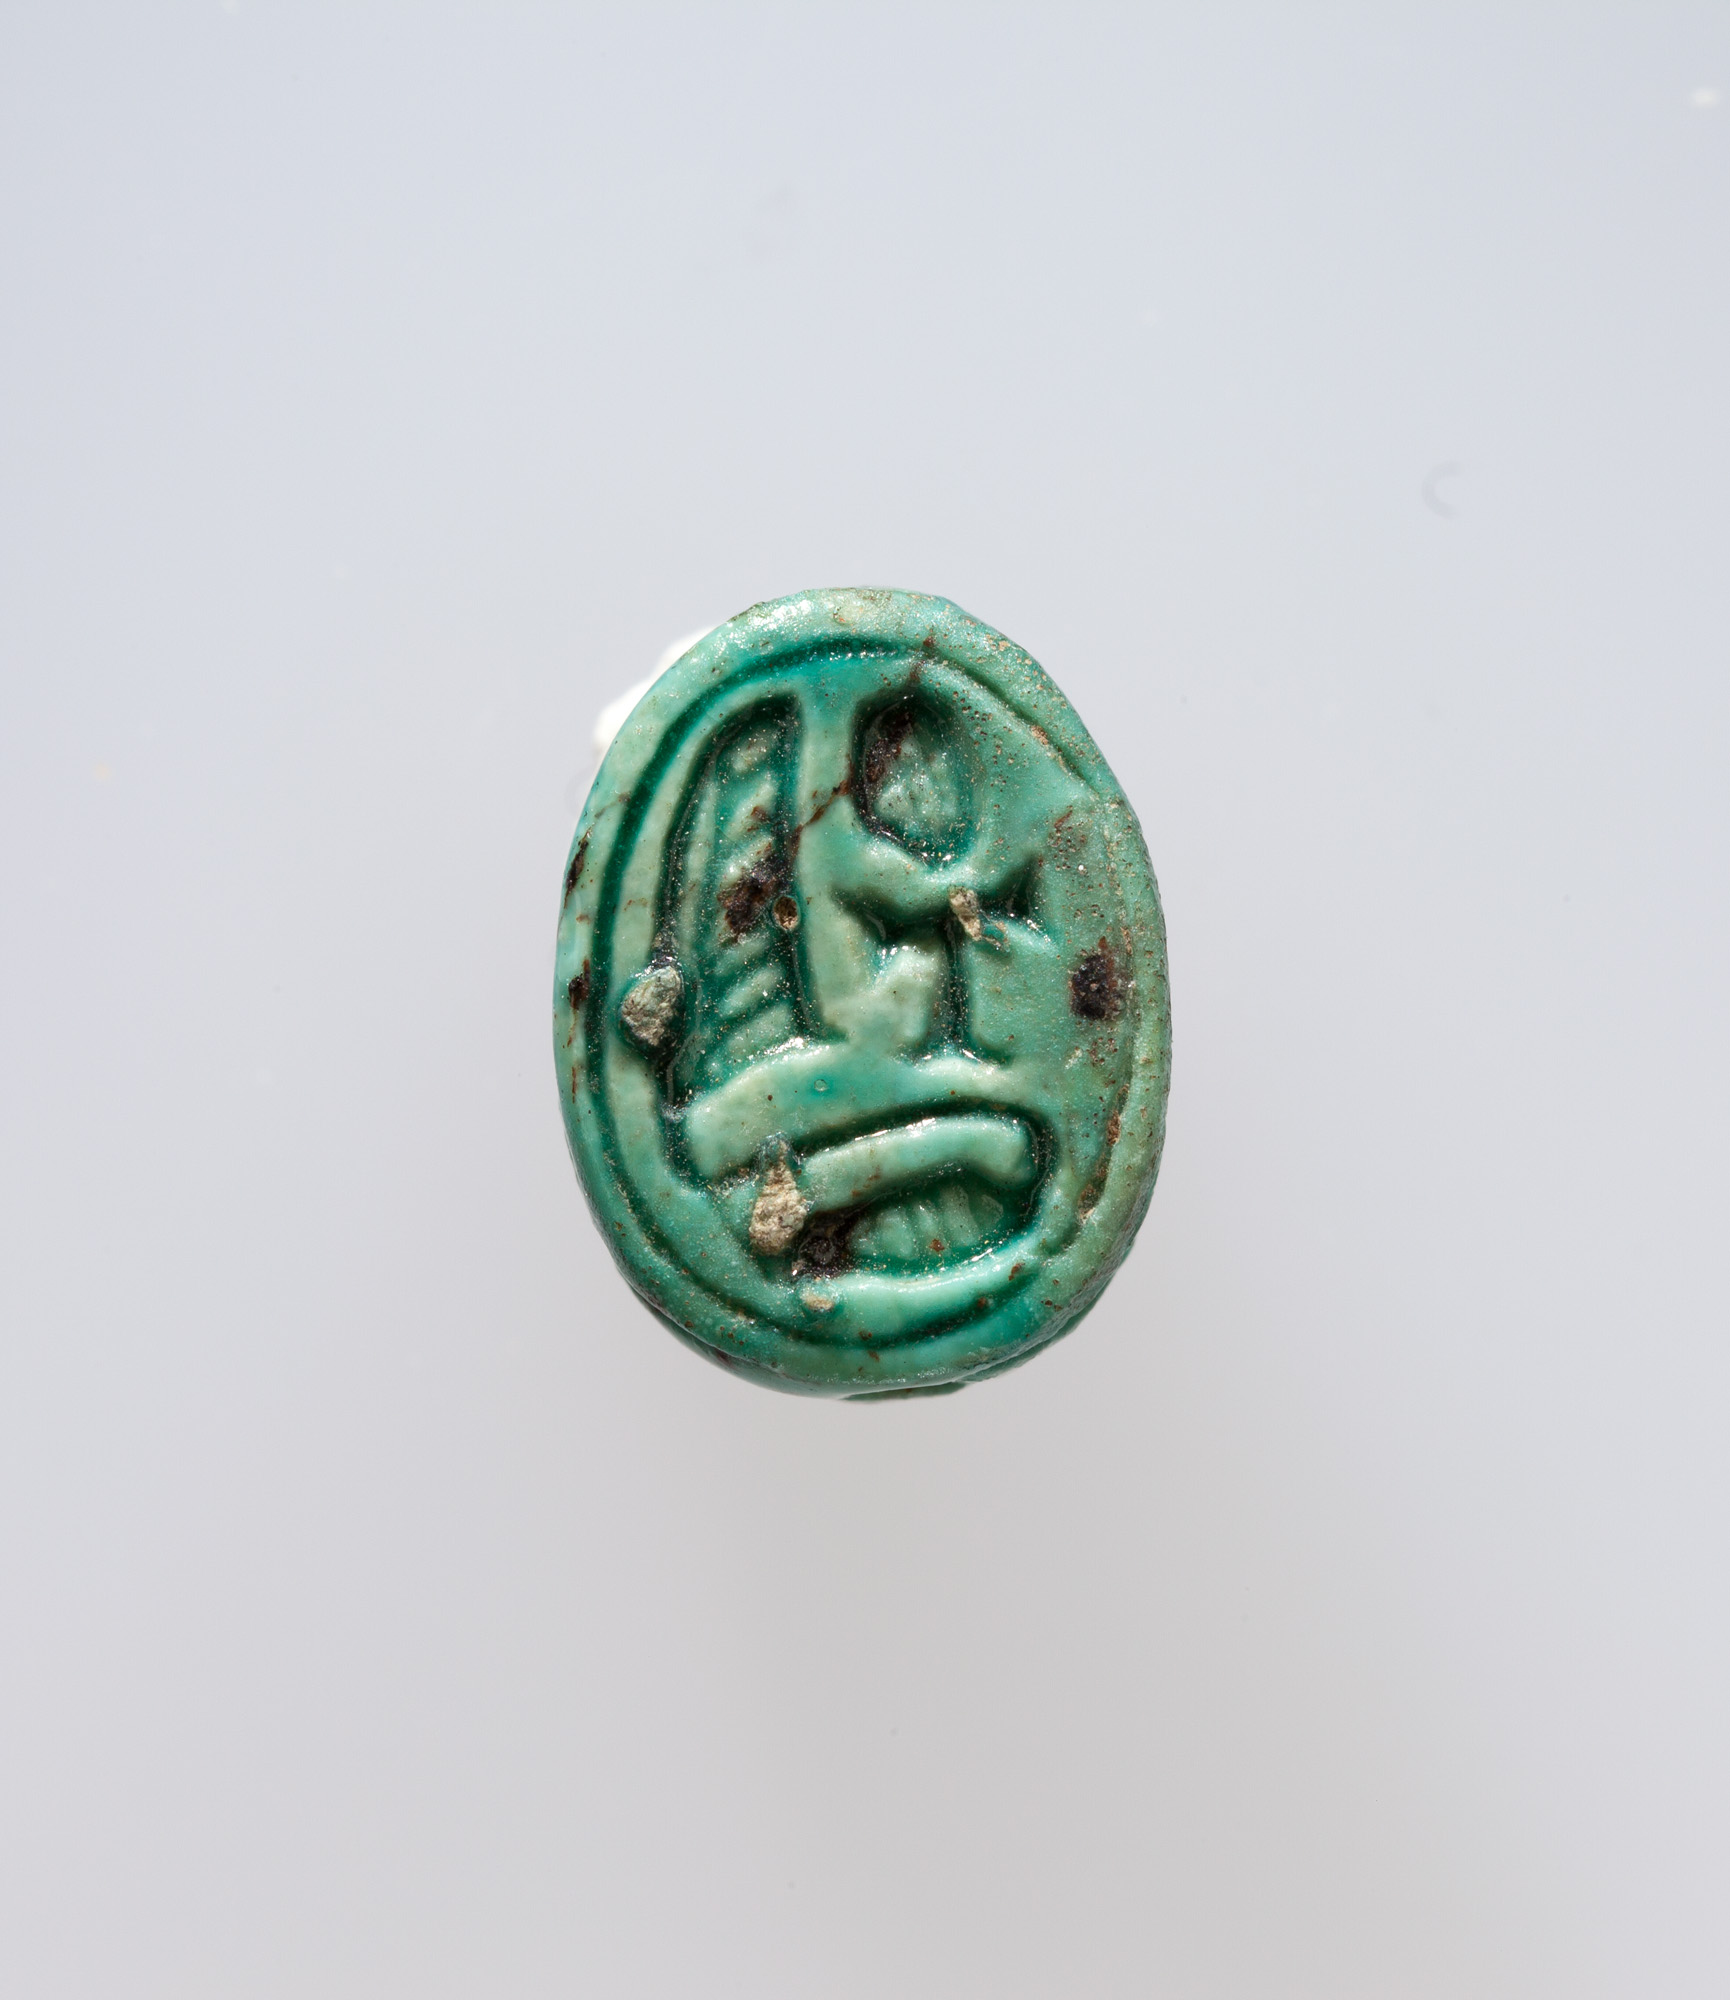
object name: scarab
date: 1479-1458 BCE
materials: faience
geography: egypt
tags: scarabs